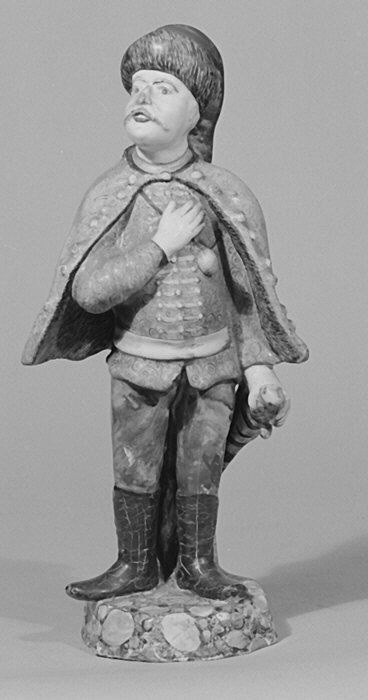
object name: figure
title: Hussar officer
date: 1750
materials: earthenware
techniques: glazing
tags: soldiers